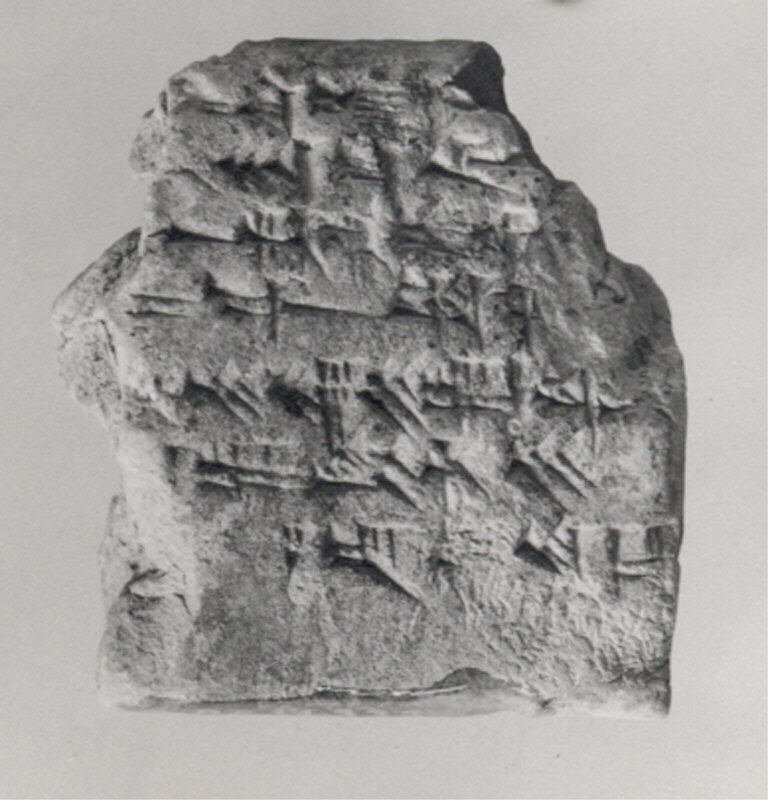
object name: cuneiform tablet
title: Cuneiform tablet: account of barley disbursements, Ebabbar archive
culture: babylonian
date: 577 BCE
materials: clay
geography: mesopotamia